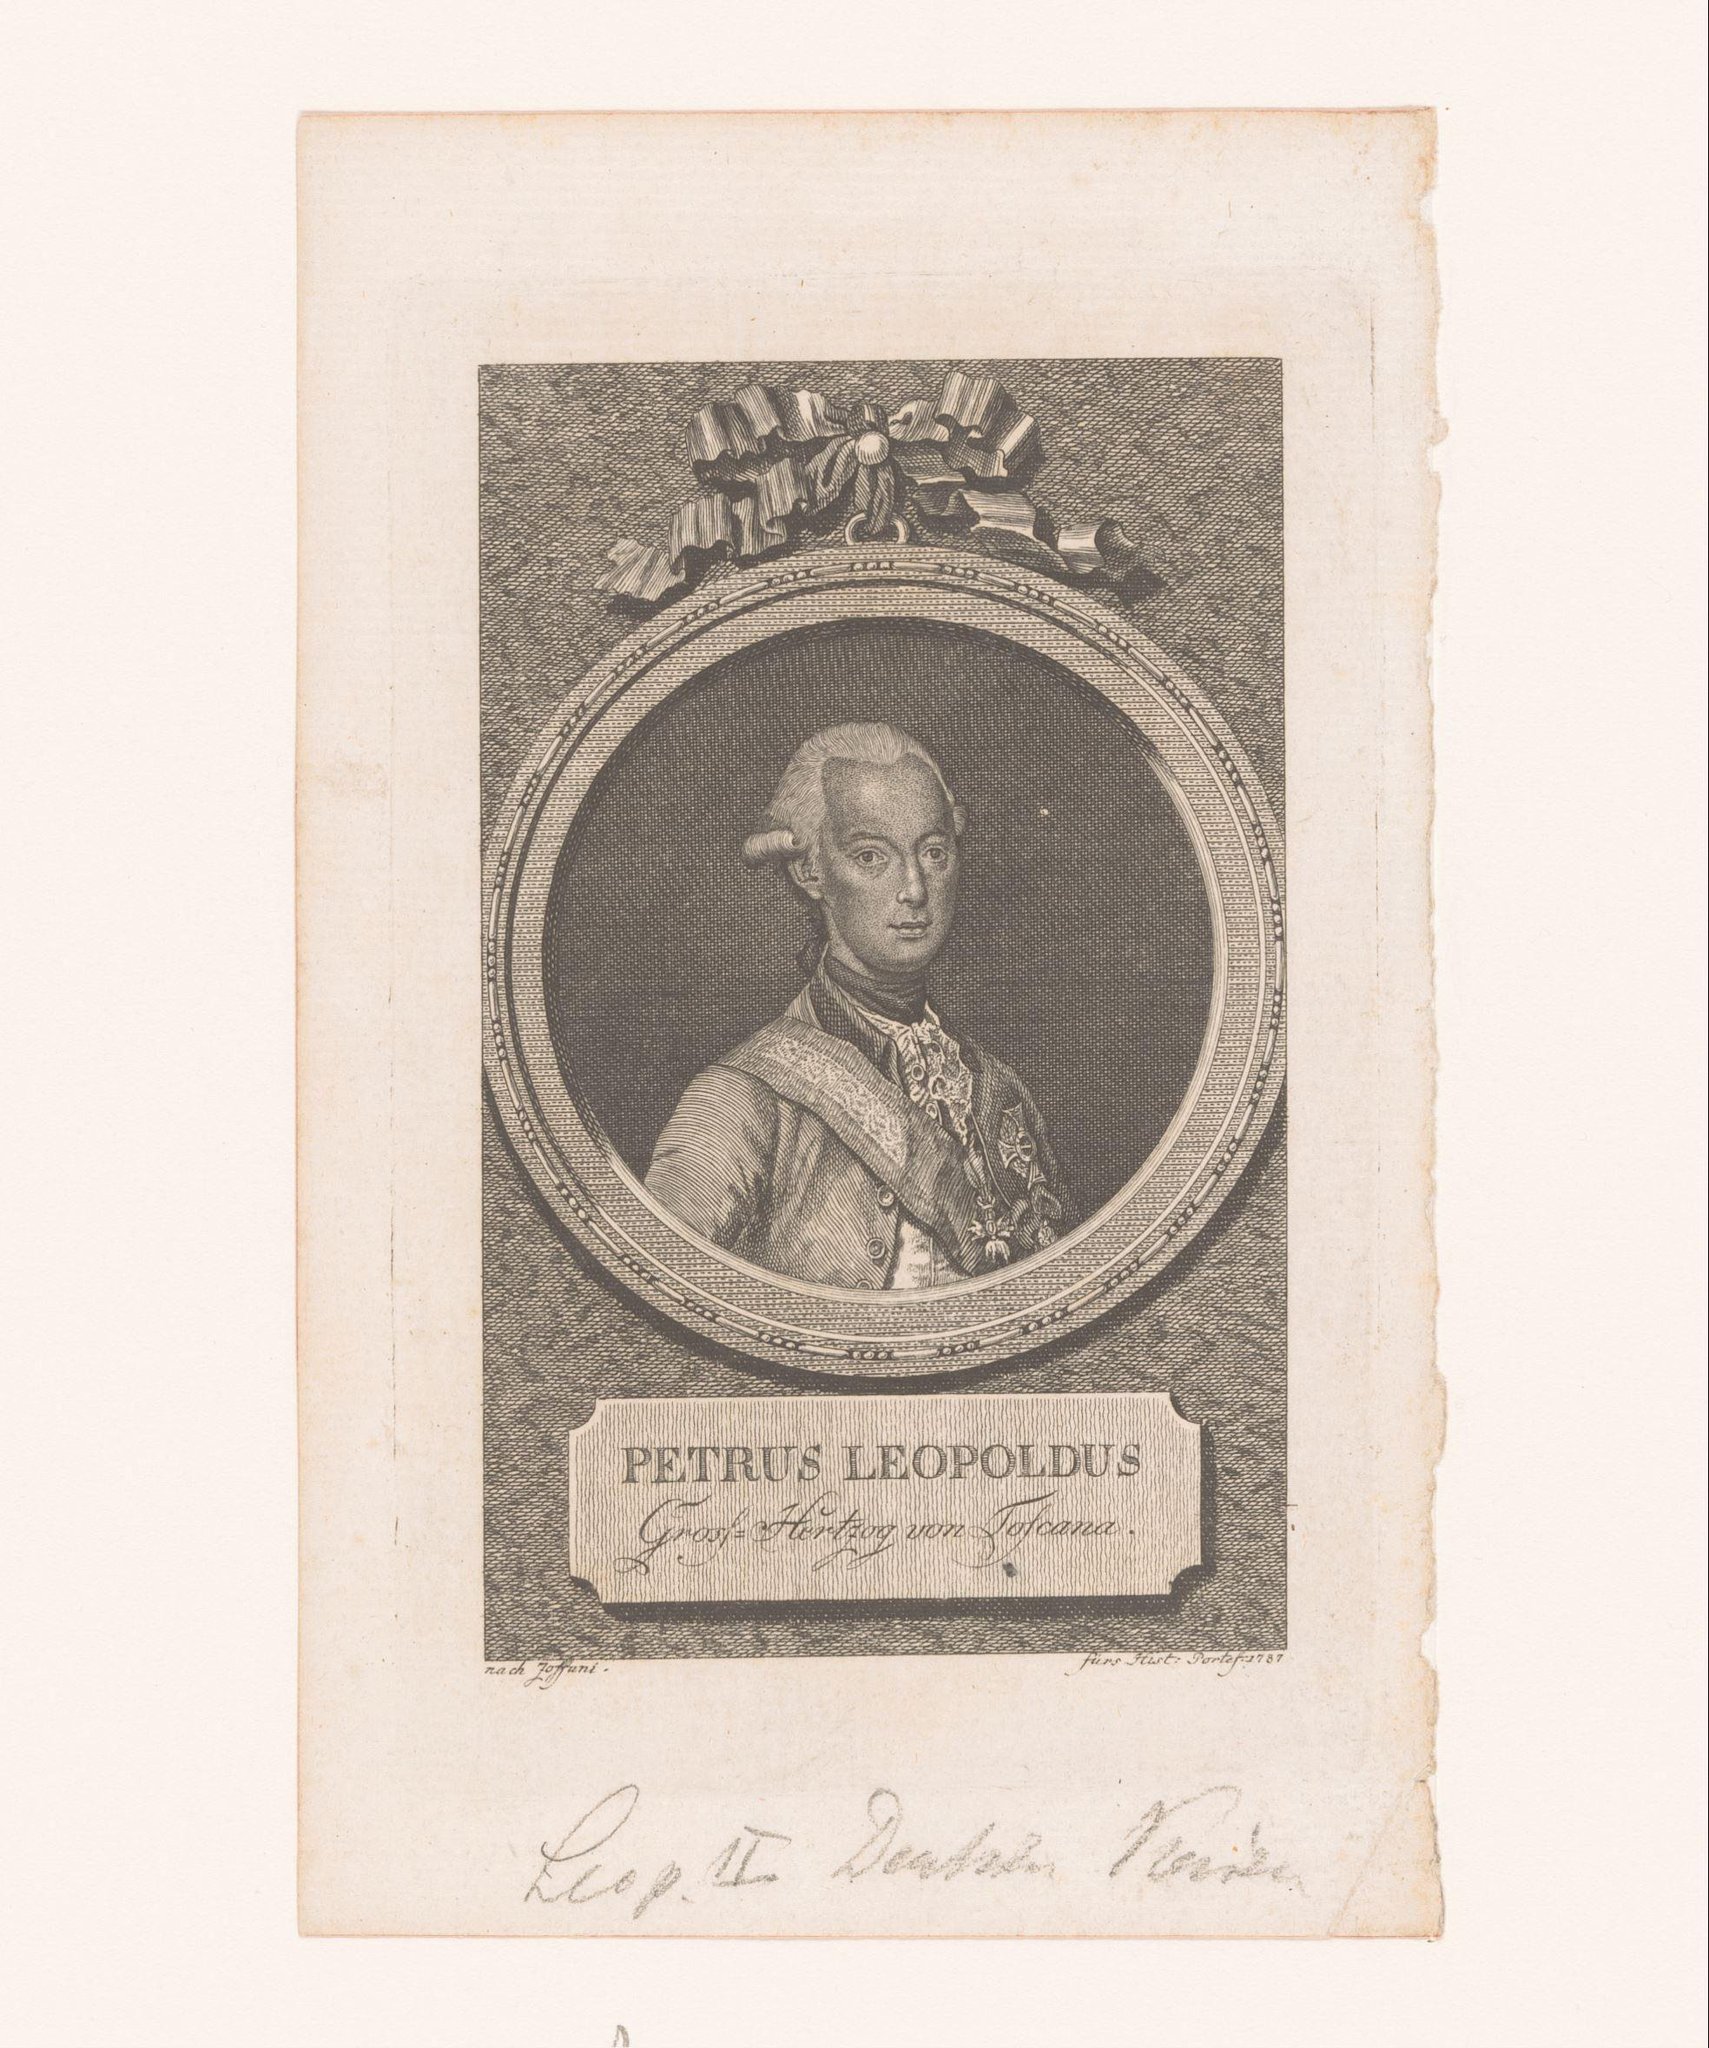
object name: print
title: Portret van Leopold II, keizer van Oostenrijk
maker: Anonymous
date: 1787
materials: paper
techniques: engraving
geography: germany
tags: leopold ii (keizer van oostenrijk), historical persons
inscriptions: collector's mark: Lugt 2228, name